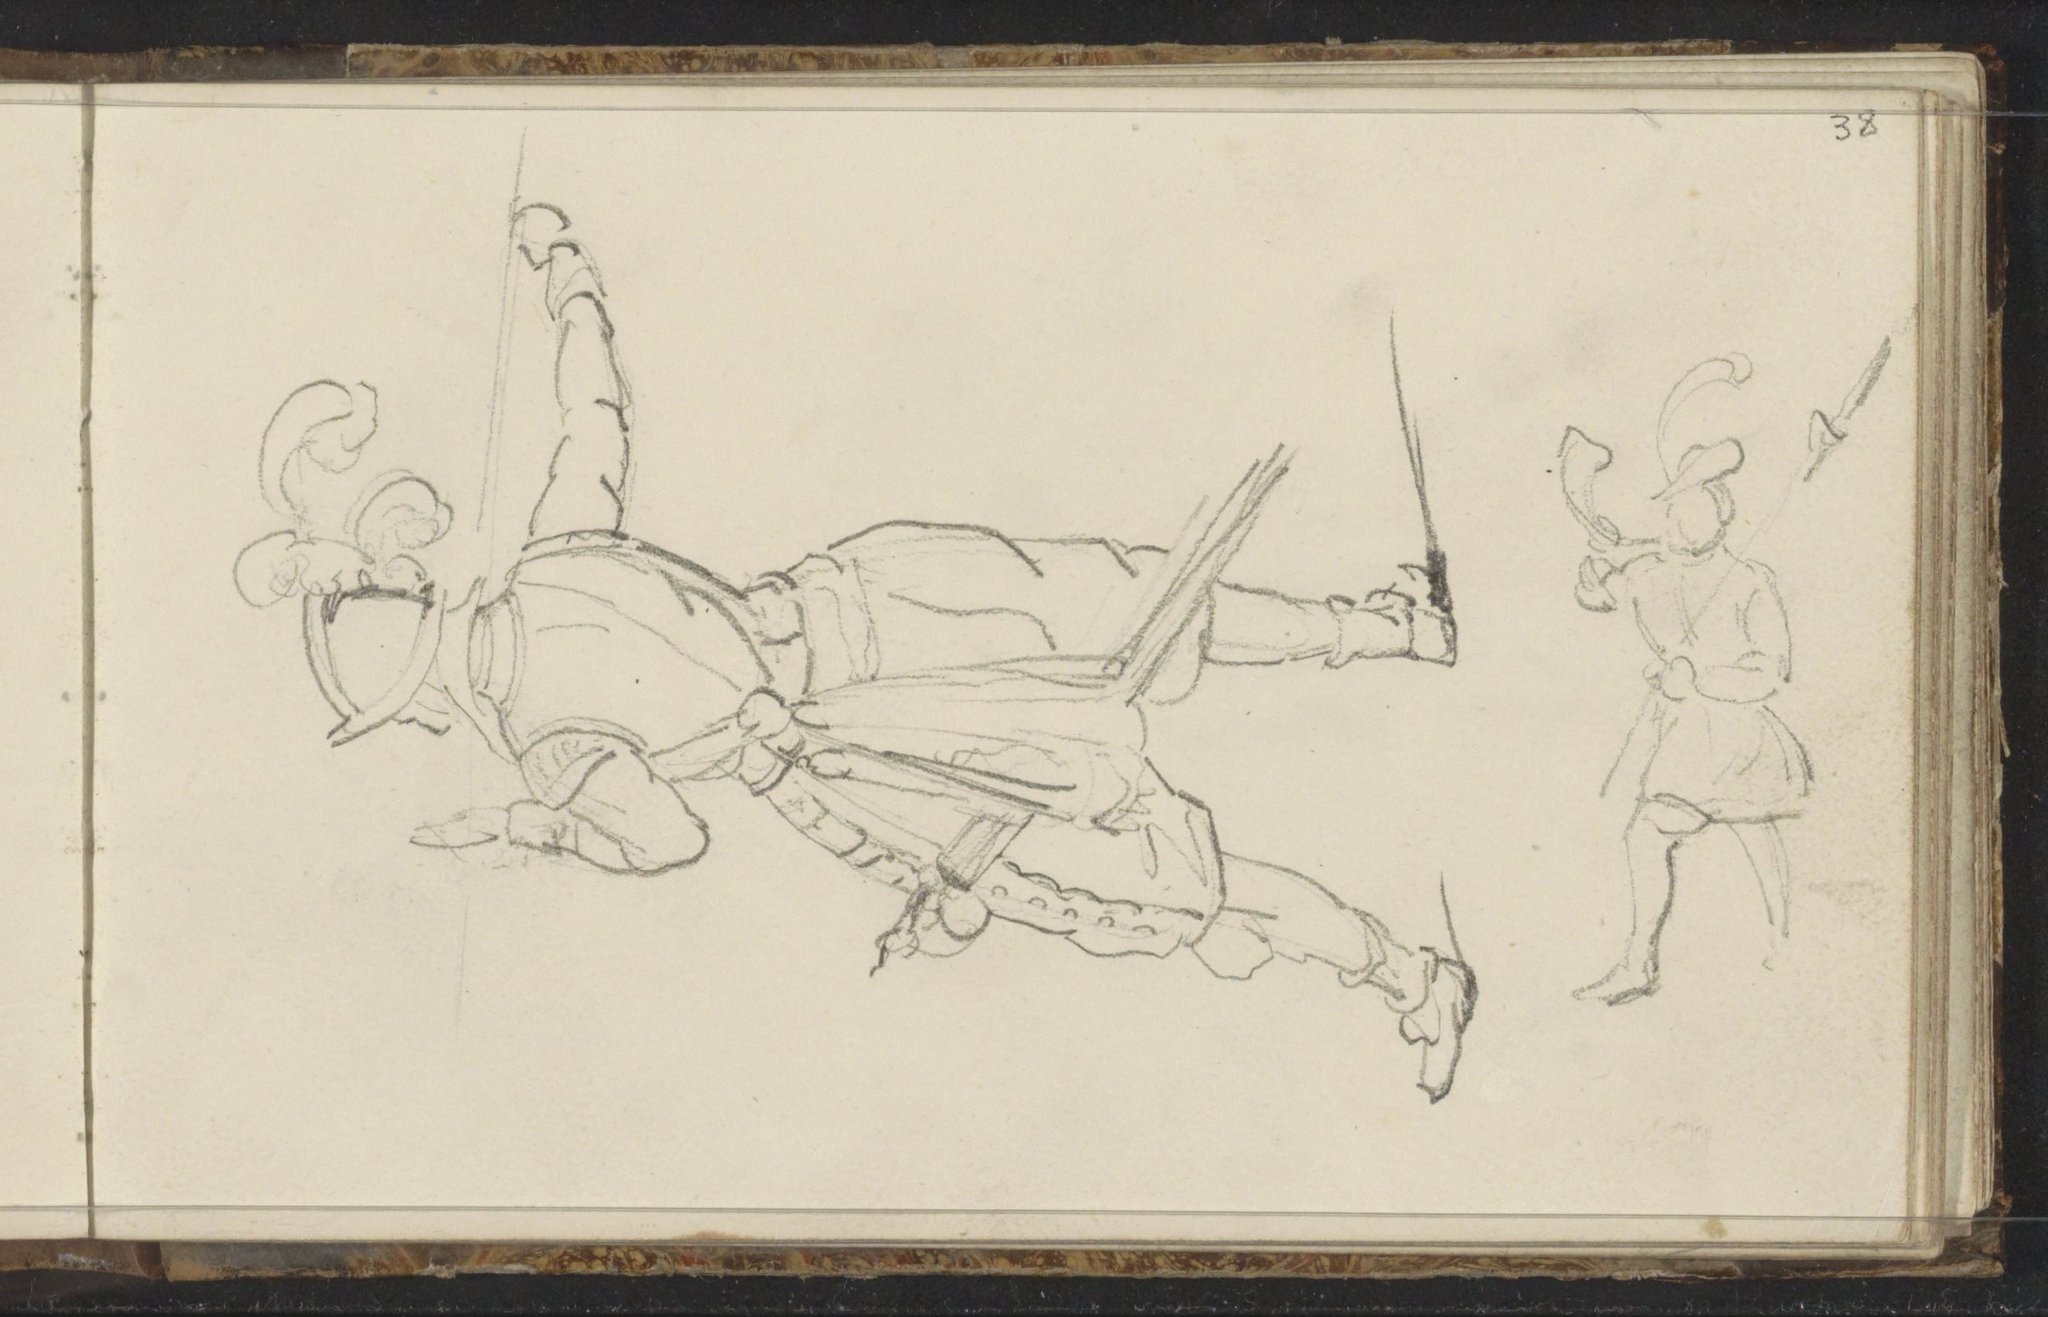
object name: sketchbook leaf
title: Soldaat met wapens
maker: willem hendrik schmidt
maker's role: draughtsman, painter, print maker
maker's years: 1809-1849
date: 1819-1849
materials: paper, pencil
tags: weapons, the soldier; the soldier's life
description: Blad 38 recto uit een schetsboek met 60 bladen.